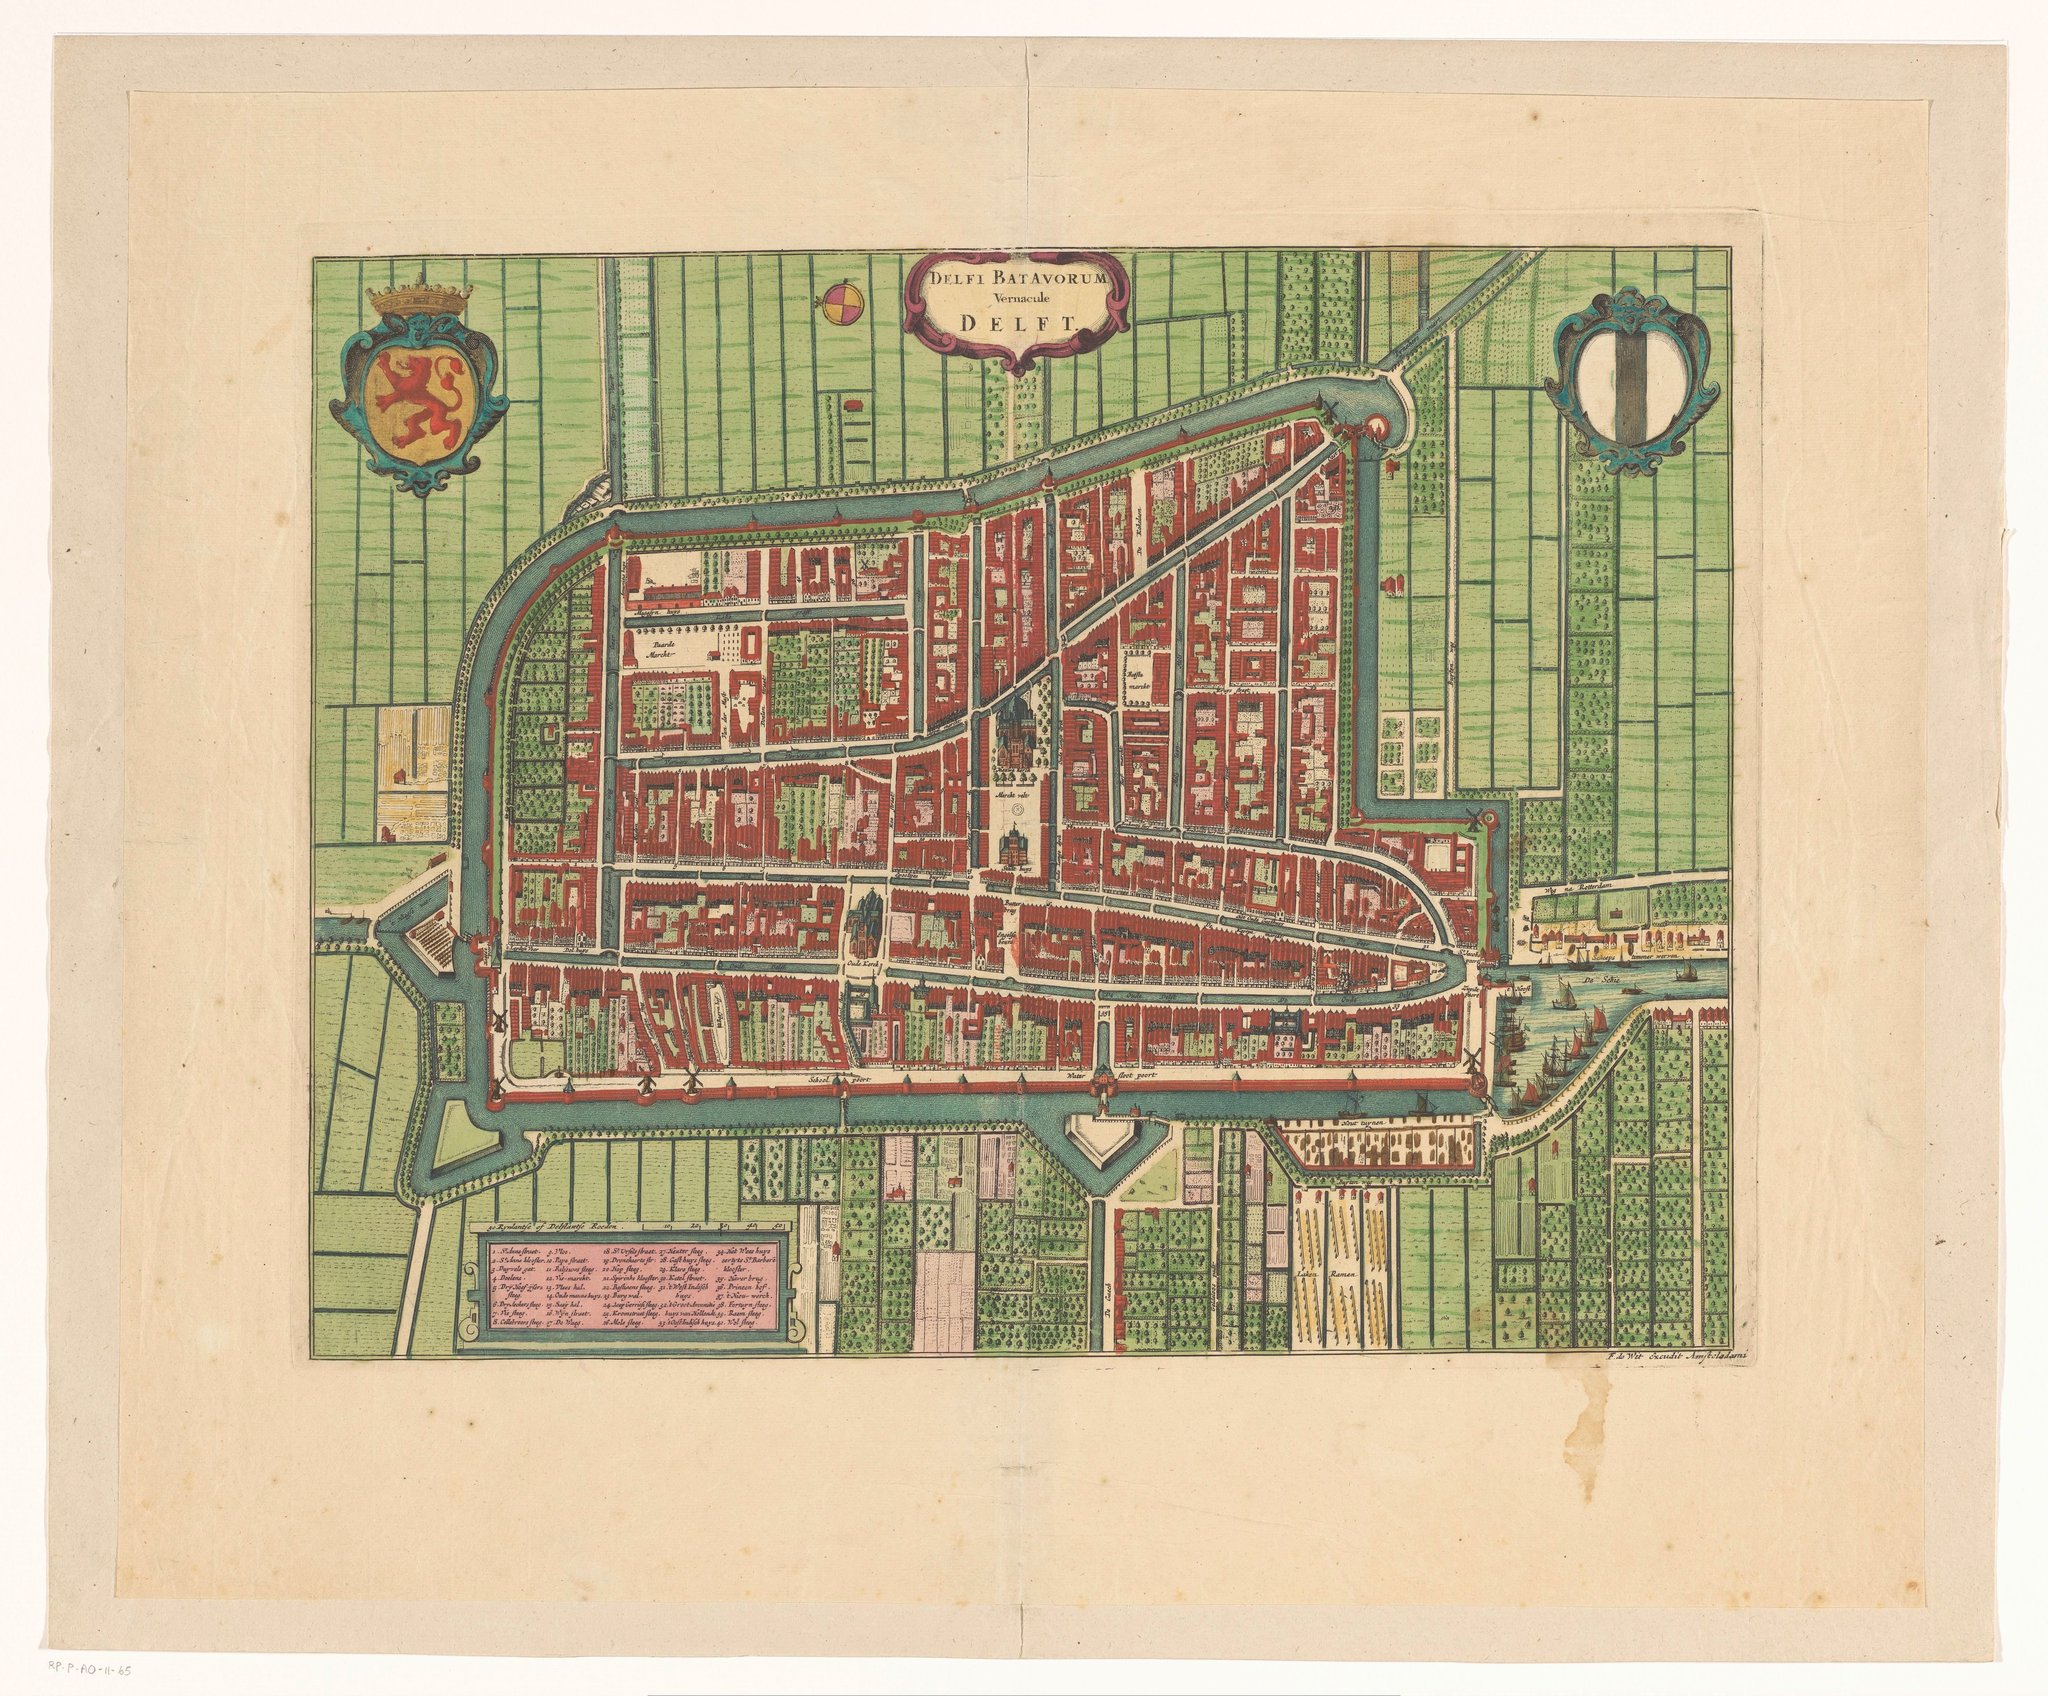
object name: print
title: Delfi Batavorum vernacule Delft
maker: Anonymous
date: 1700-1728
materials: paper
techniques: engraving, etching, hand coloring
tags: coat of arms (as symbol of the state, etc.) (+ city; municipal), maps of cities, coat of arms (as symbol of the state, etc.) (+ province; provincial), delft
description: Deze staat van prent ook gebruikt in: Theatrum ichnographicum omnium urbium et praecipuorum oppidorum Belgicarum XVII Provinciarum (…). Amsterdam: Frederik de Wit, ca. 1700-1710. En in: Aa, Pieter van der. La galerie agreable du monde (...). 66 delen. Leiden: Pieter van der Aa, 1728, dl. 18.